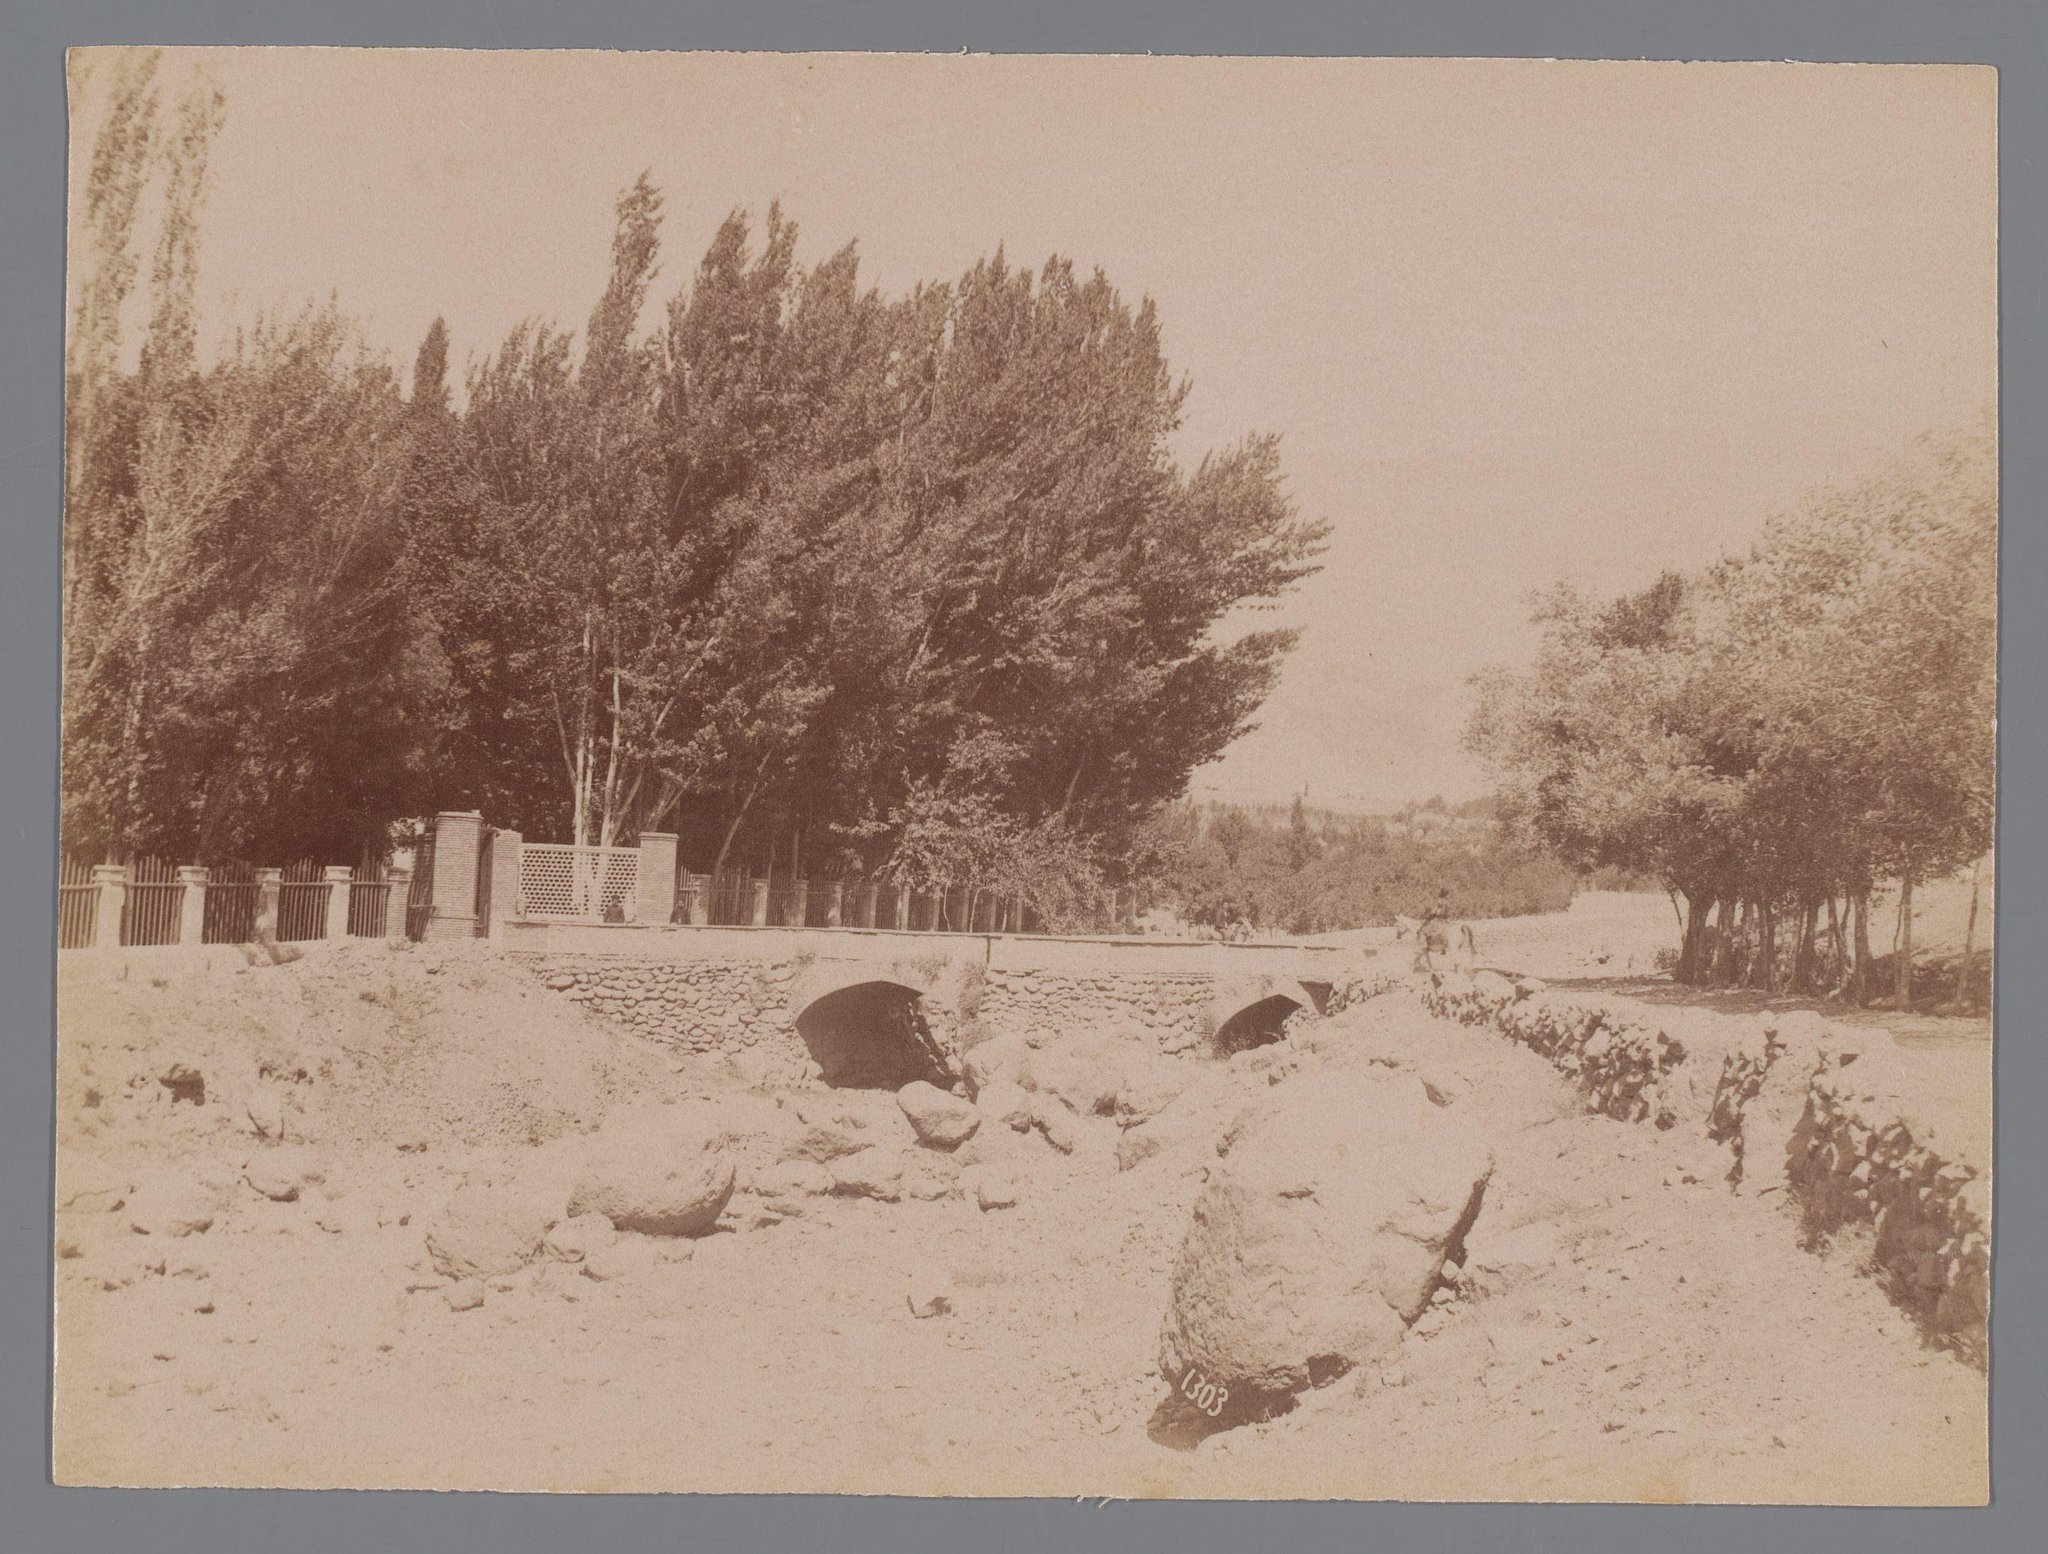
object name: photograph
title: Zerguenebeh [?], Iran [?]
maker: antoine sevruguin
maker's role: fotograaf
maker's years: 1840-1933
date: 1880-1910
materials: paper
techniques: albumen print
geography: iran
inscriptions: inscription: ‘Zerguenebeh’